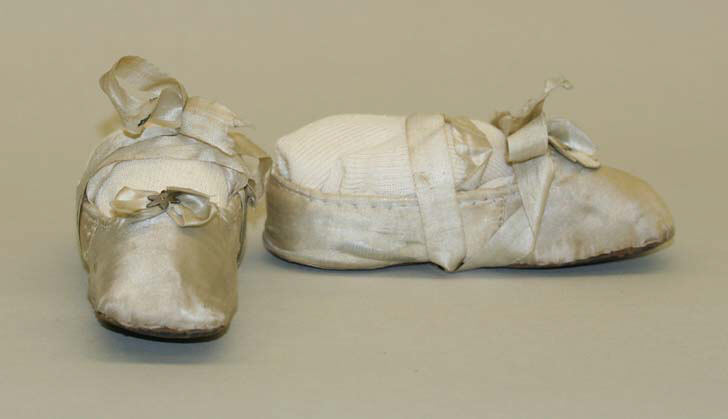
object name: slipper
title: Slippers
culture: american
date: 1830-1840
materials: cotton, leather, metal, silk